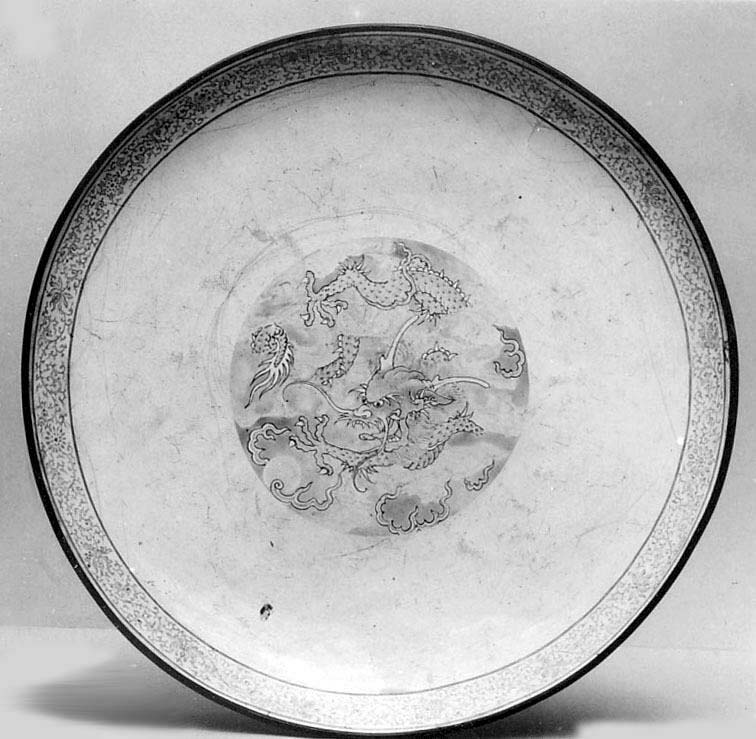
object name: dish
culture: chinese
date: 1801-1900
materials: enamel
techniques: painting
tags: dragons